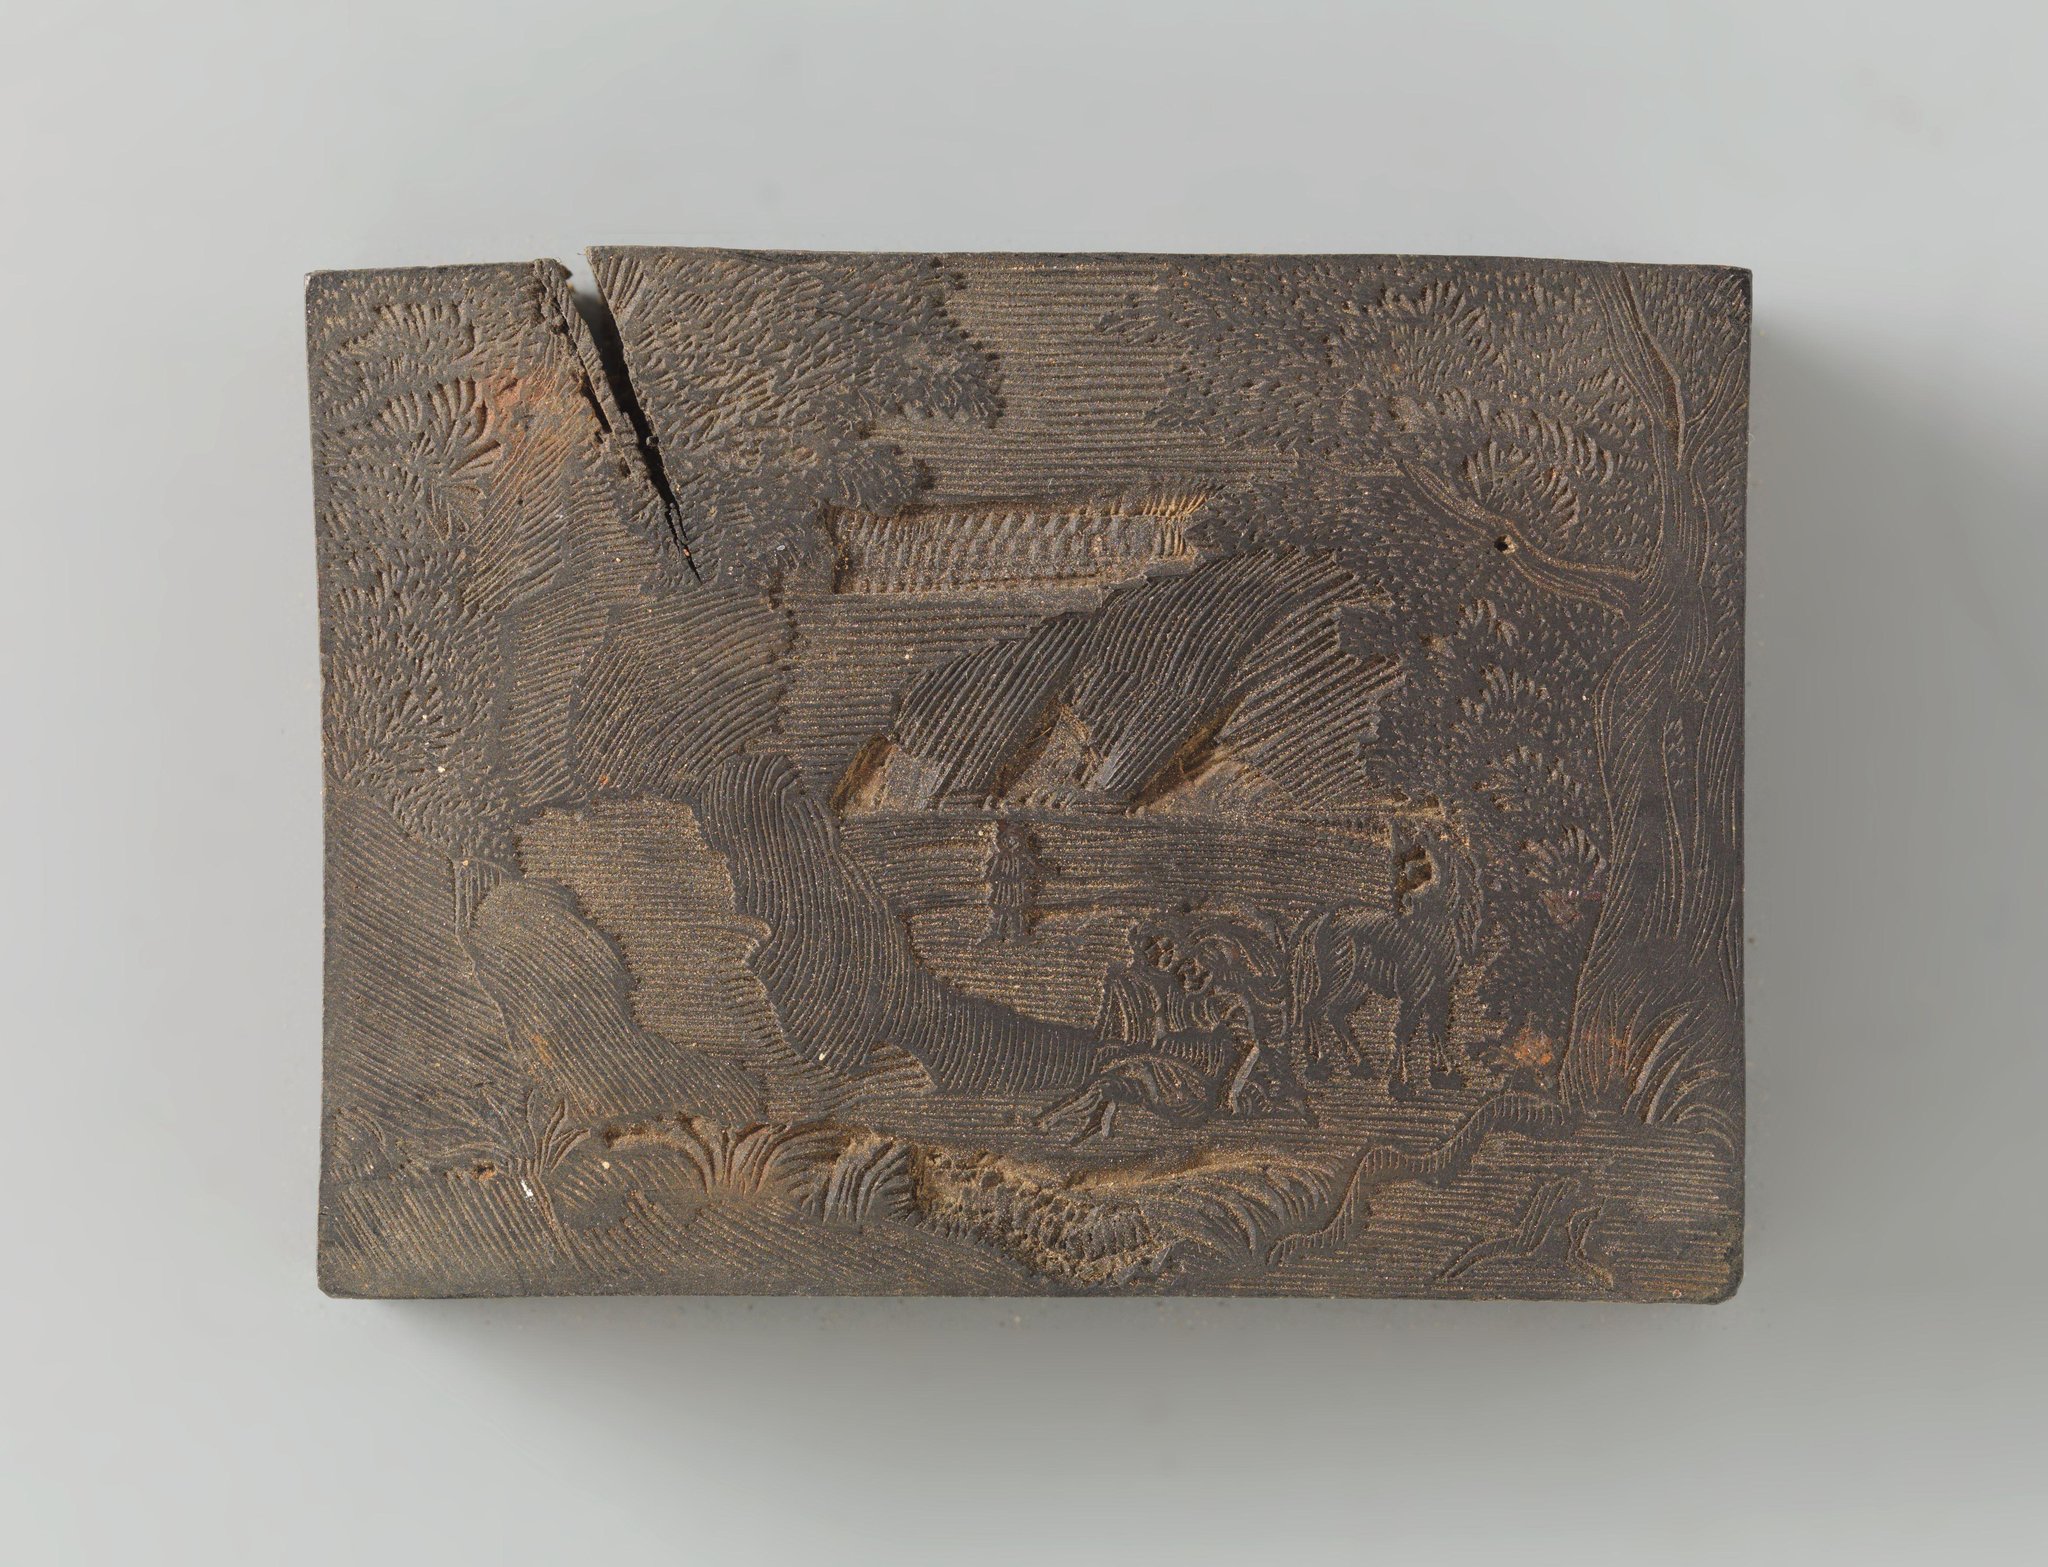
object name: wood block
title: Bijbel-illustraties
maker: Anonymous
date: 1550-1699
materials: wood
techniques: woodcut